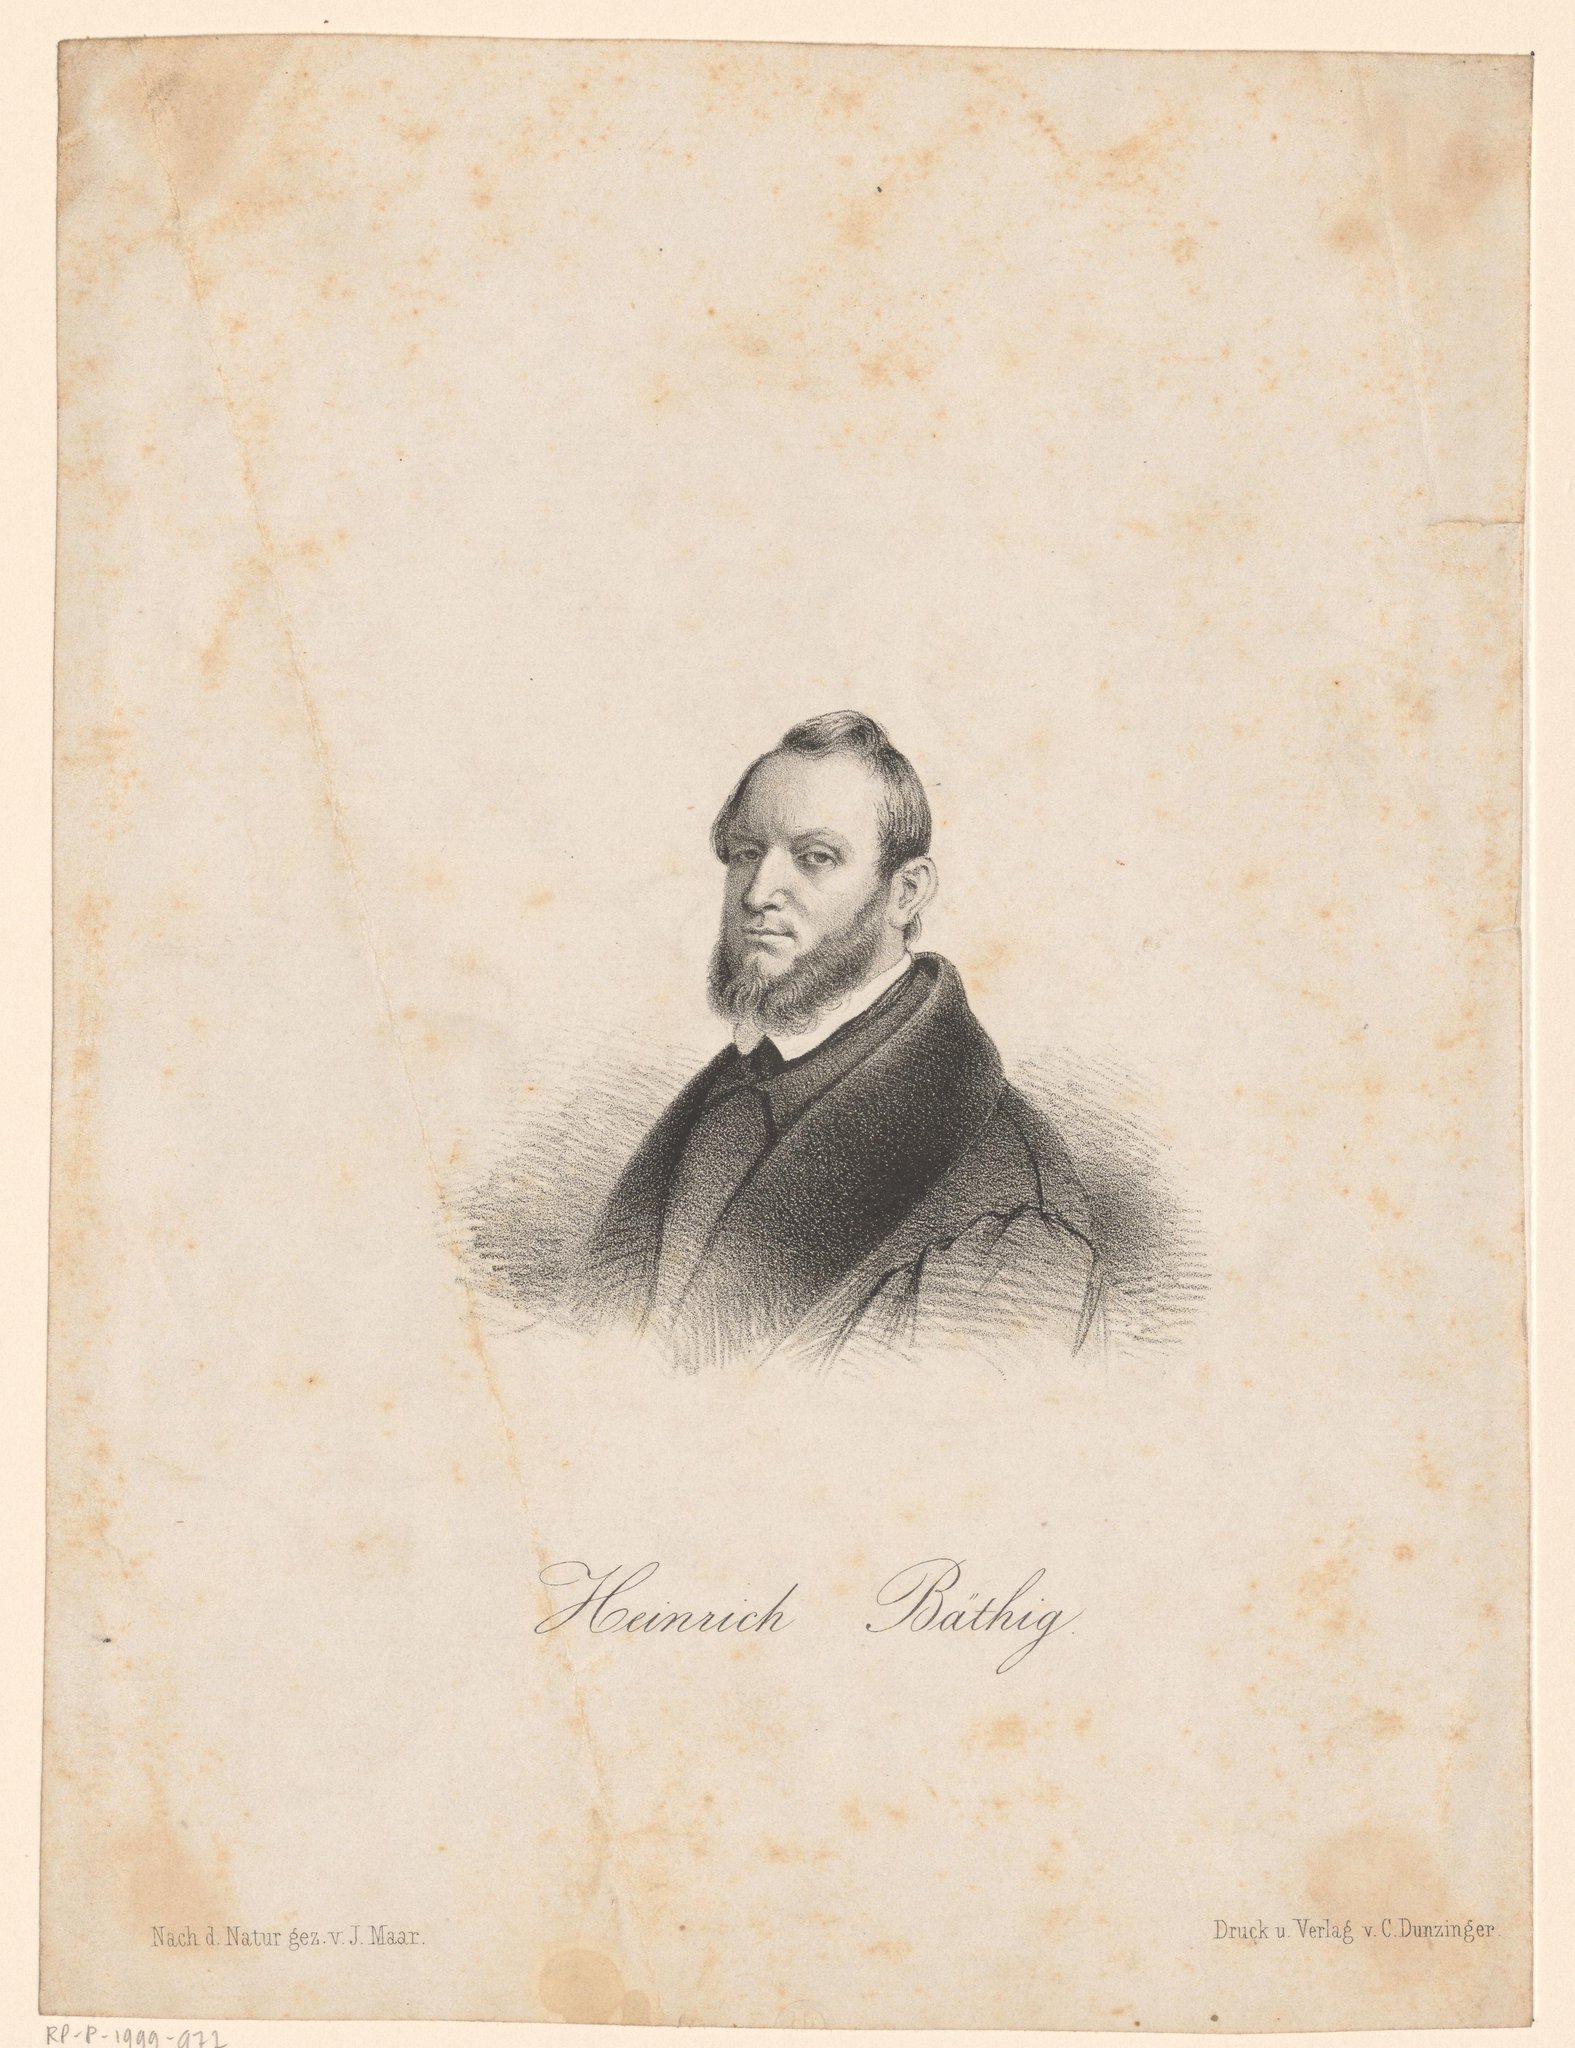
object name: print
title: Portret van Heinrich Bäthig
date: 1850-1899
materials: paper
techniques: lithograph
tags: historical persons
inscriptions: collector's mark: Lugt 2228, collector's mark: Lugt 2760